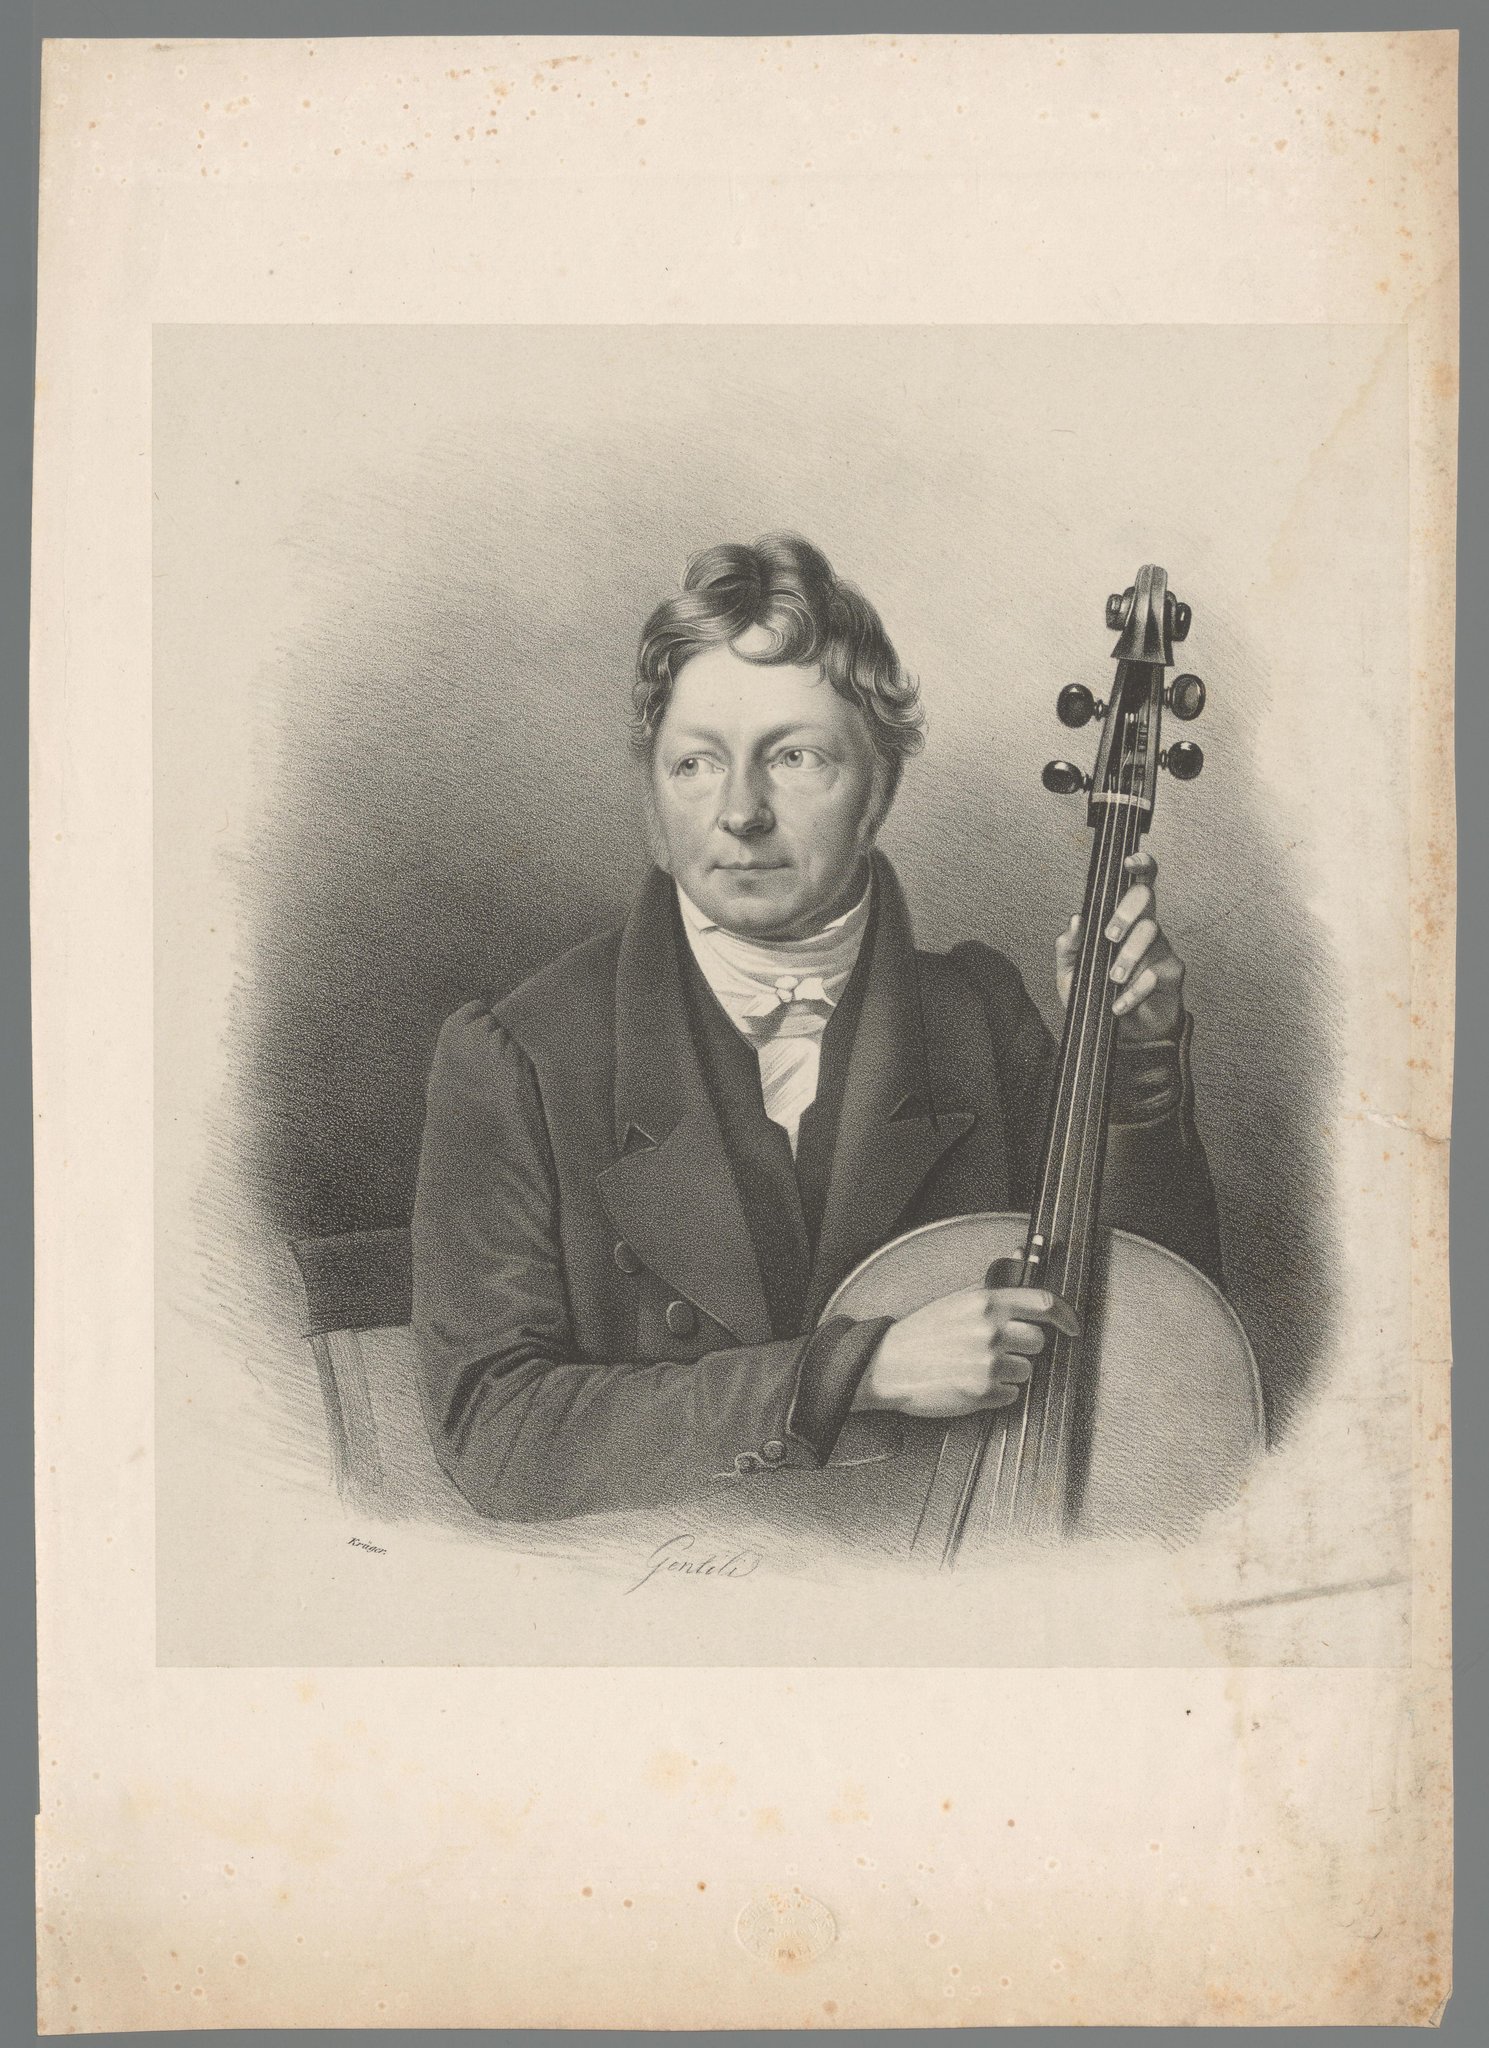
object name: print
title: Portret van Bernhard Romberg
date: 1826-1840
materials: paper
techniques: lithograph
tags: historical persons, portrait of composer, viola, violoncello; double bass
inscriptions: collector's mark: Lugt 2228, check stamp: Lugt 5415